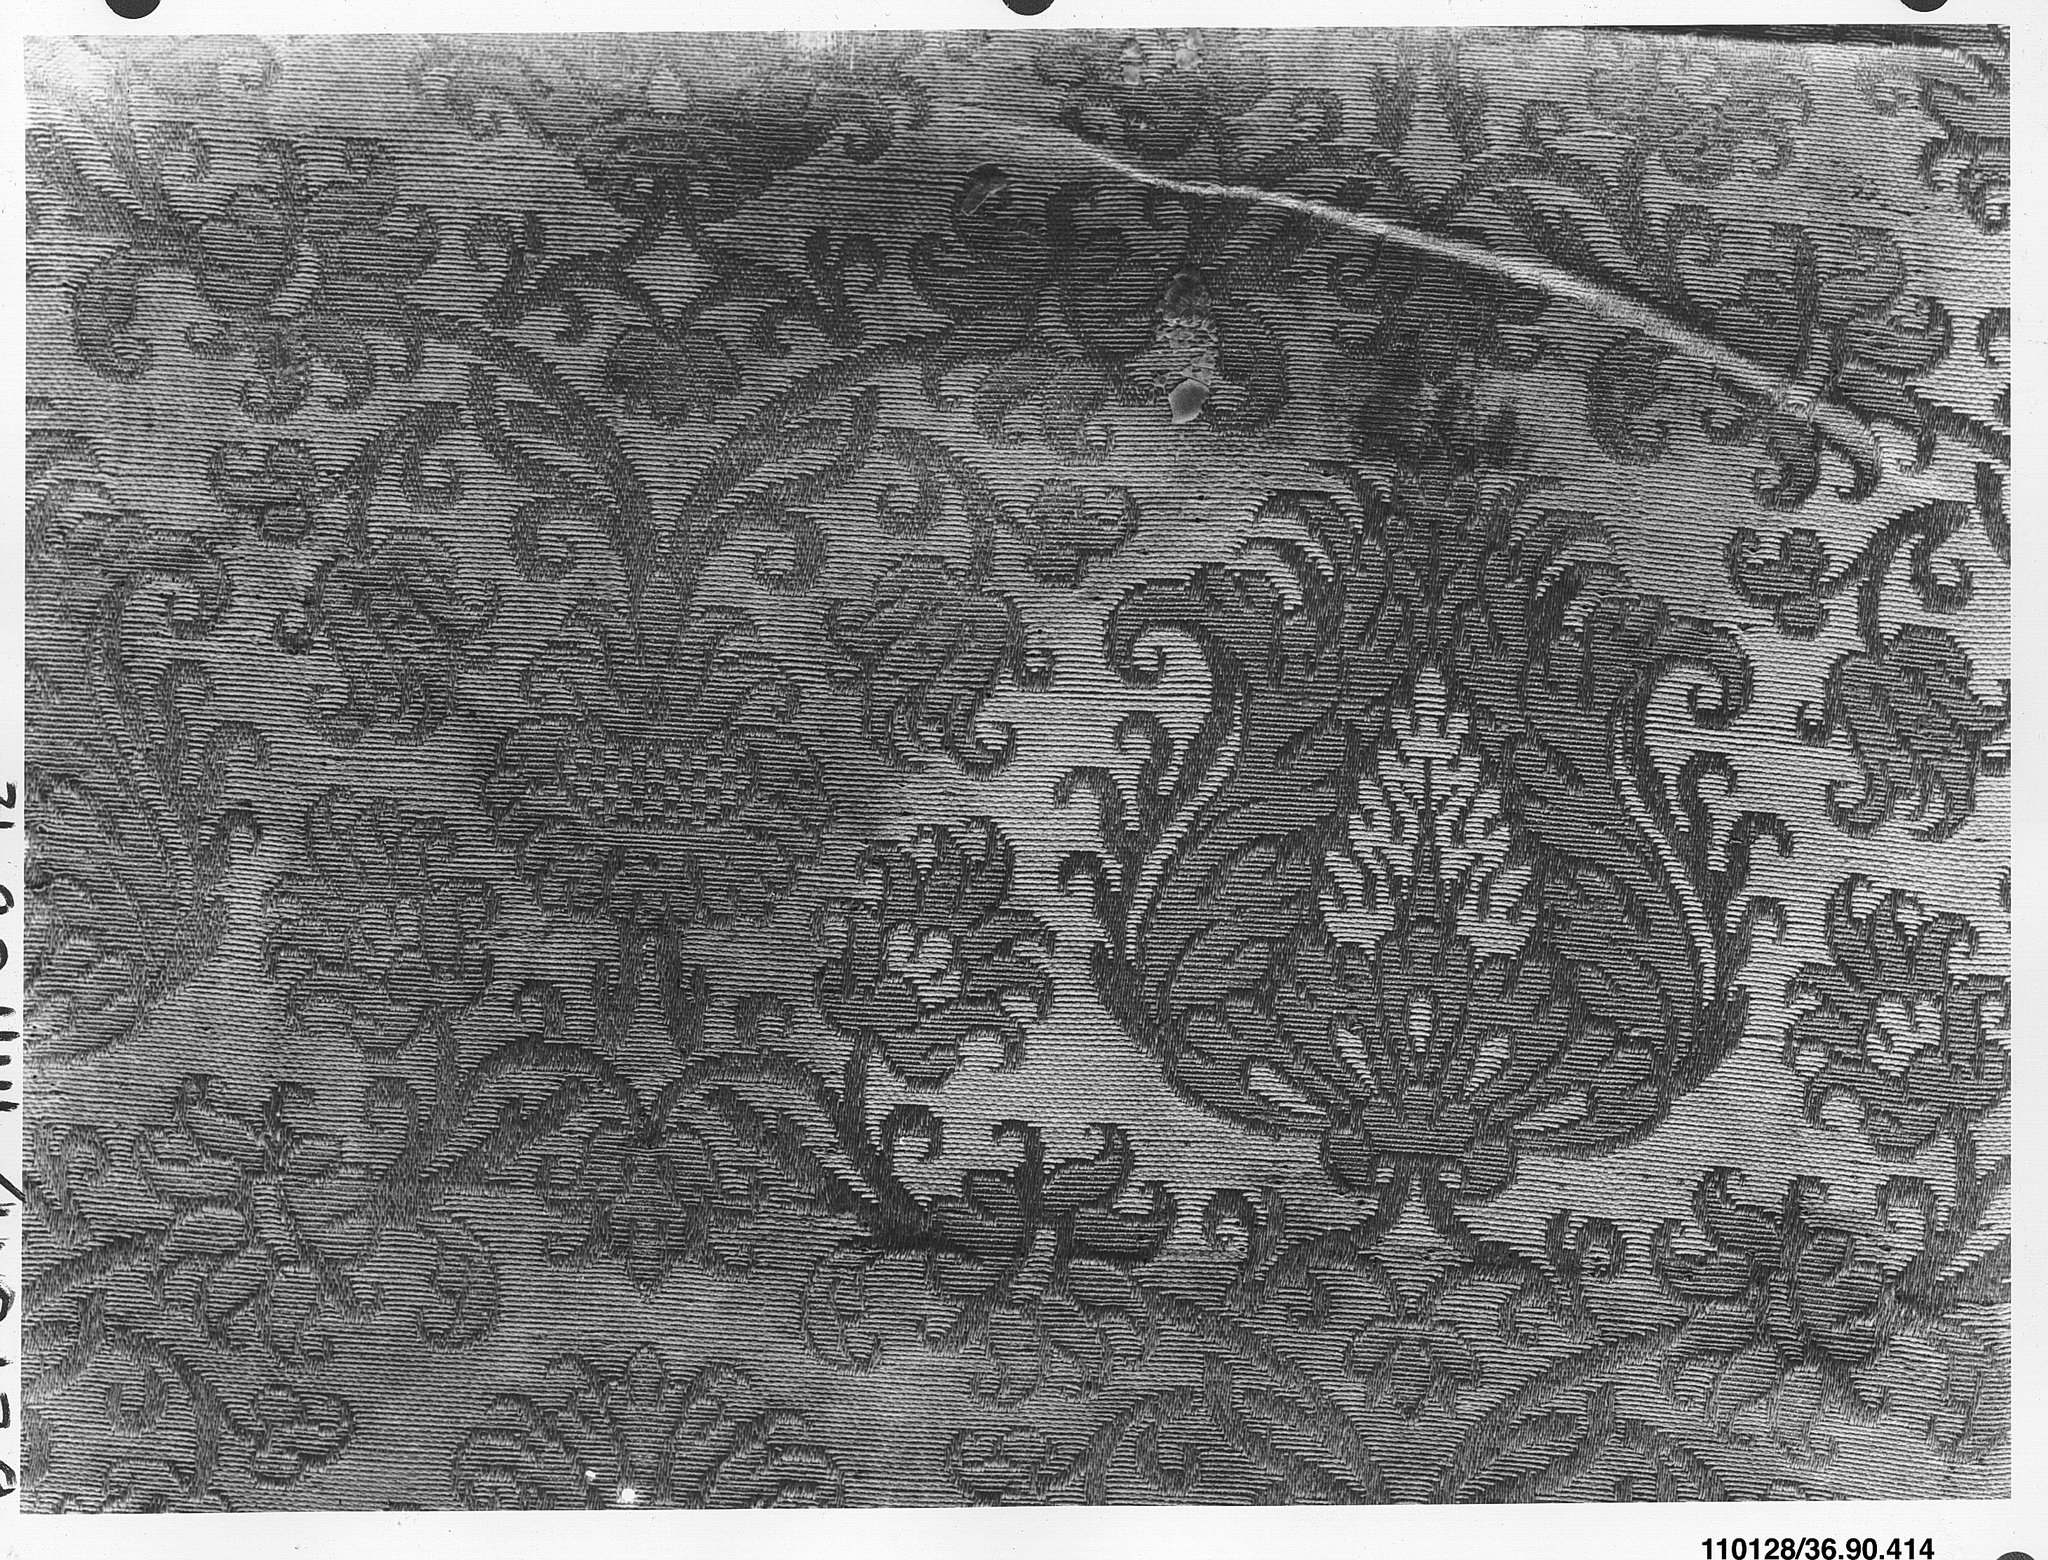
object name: piece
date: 1501-1700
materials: metal thread, silk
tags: flowers